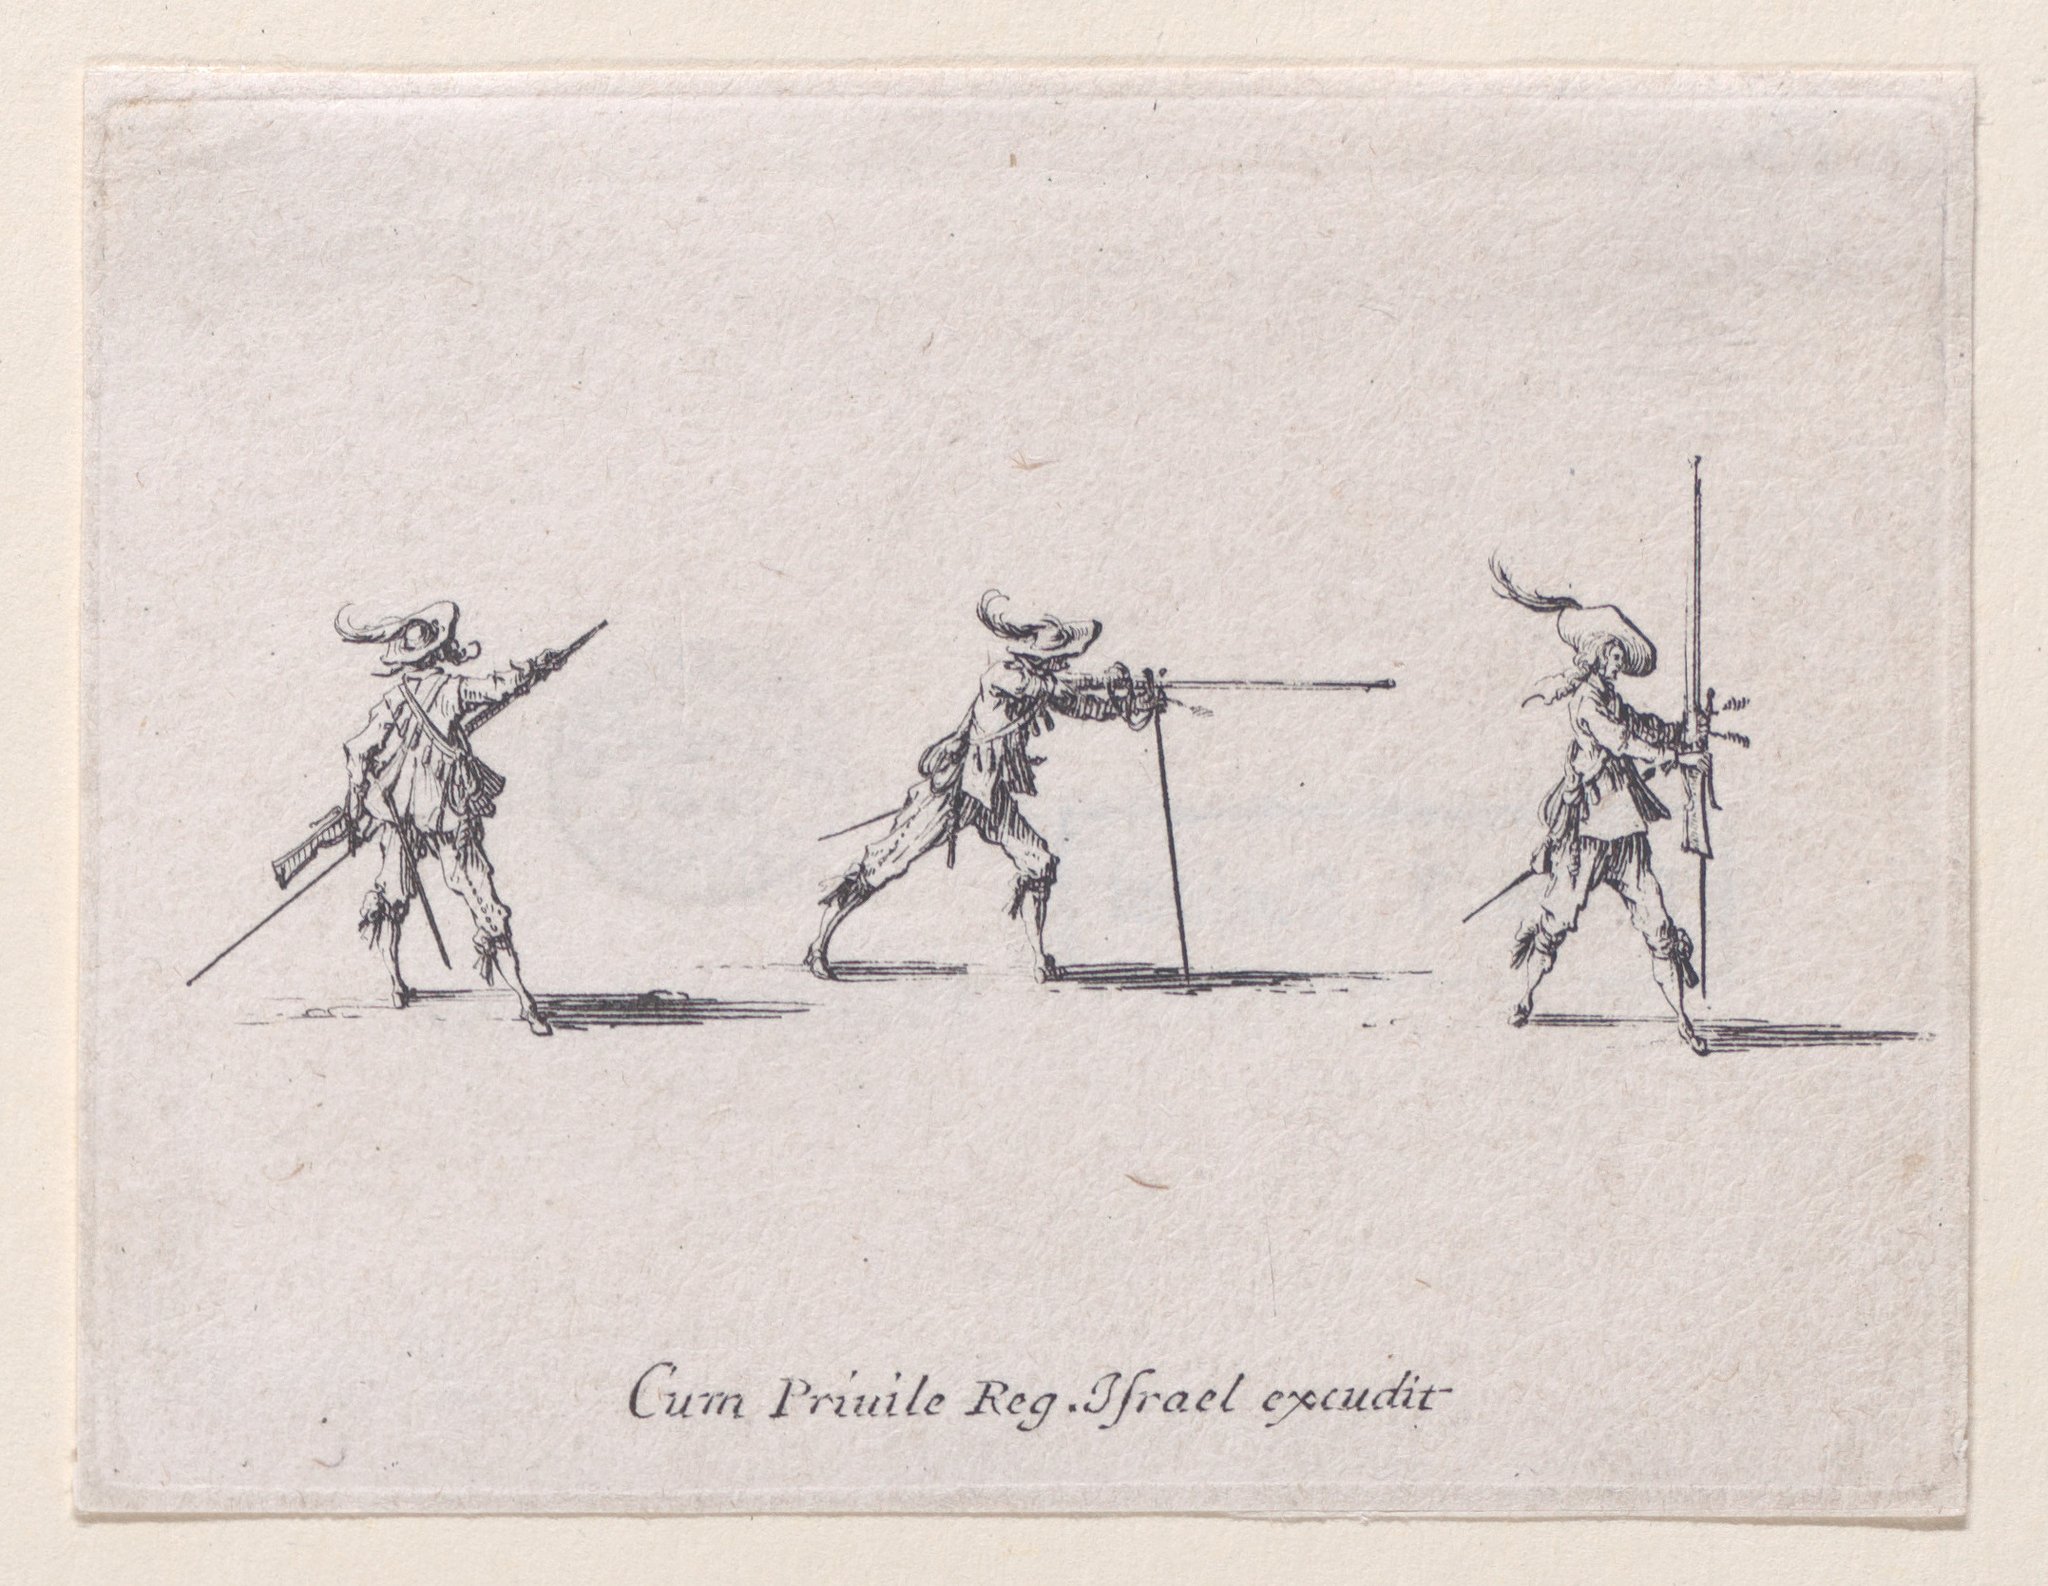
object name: print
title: L'Exercice de L'Arquebuse: La Preparation au Tir (Drill of the Arquebus: Preparing to Shoot), from "Les Exercices Militaires" (The Military Exercises)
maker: jacques callot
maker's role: artist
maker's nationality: french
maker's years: 1592-1635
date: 1635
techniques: etching